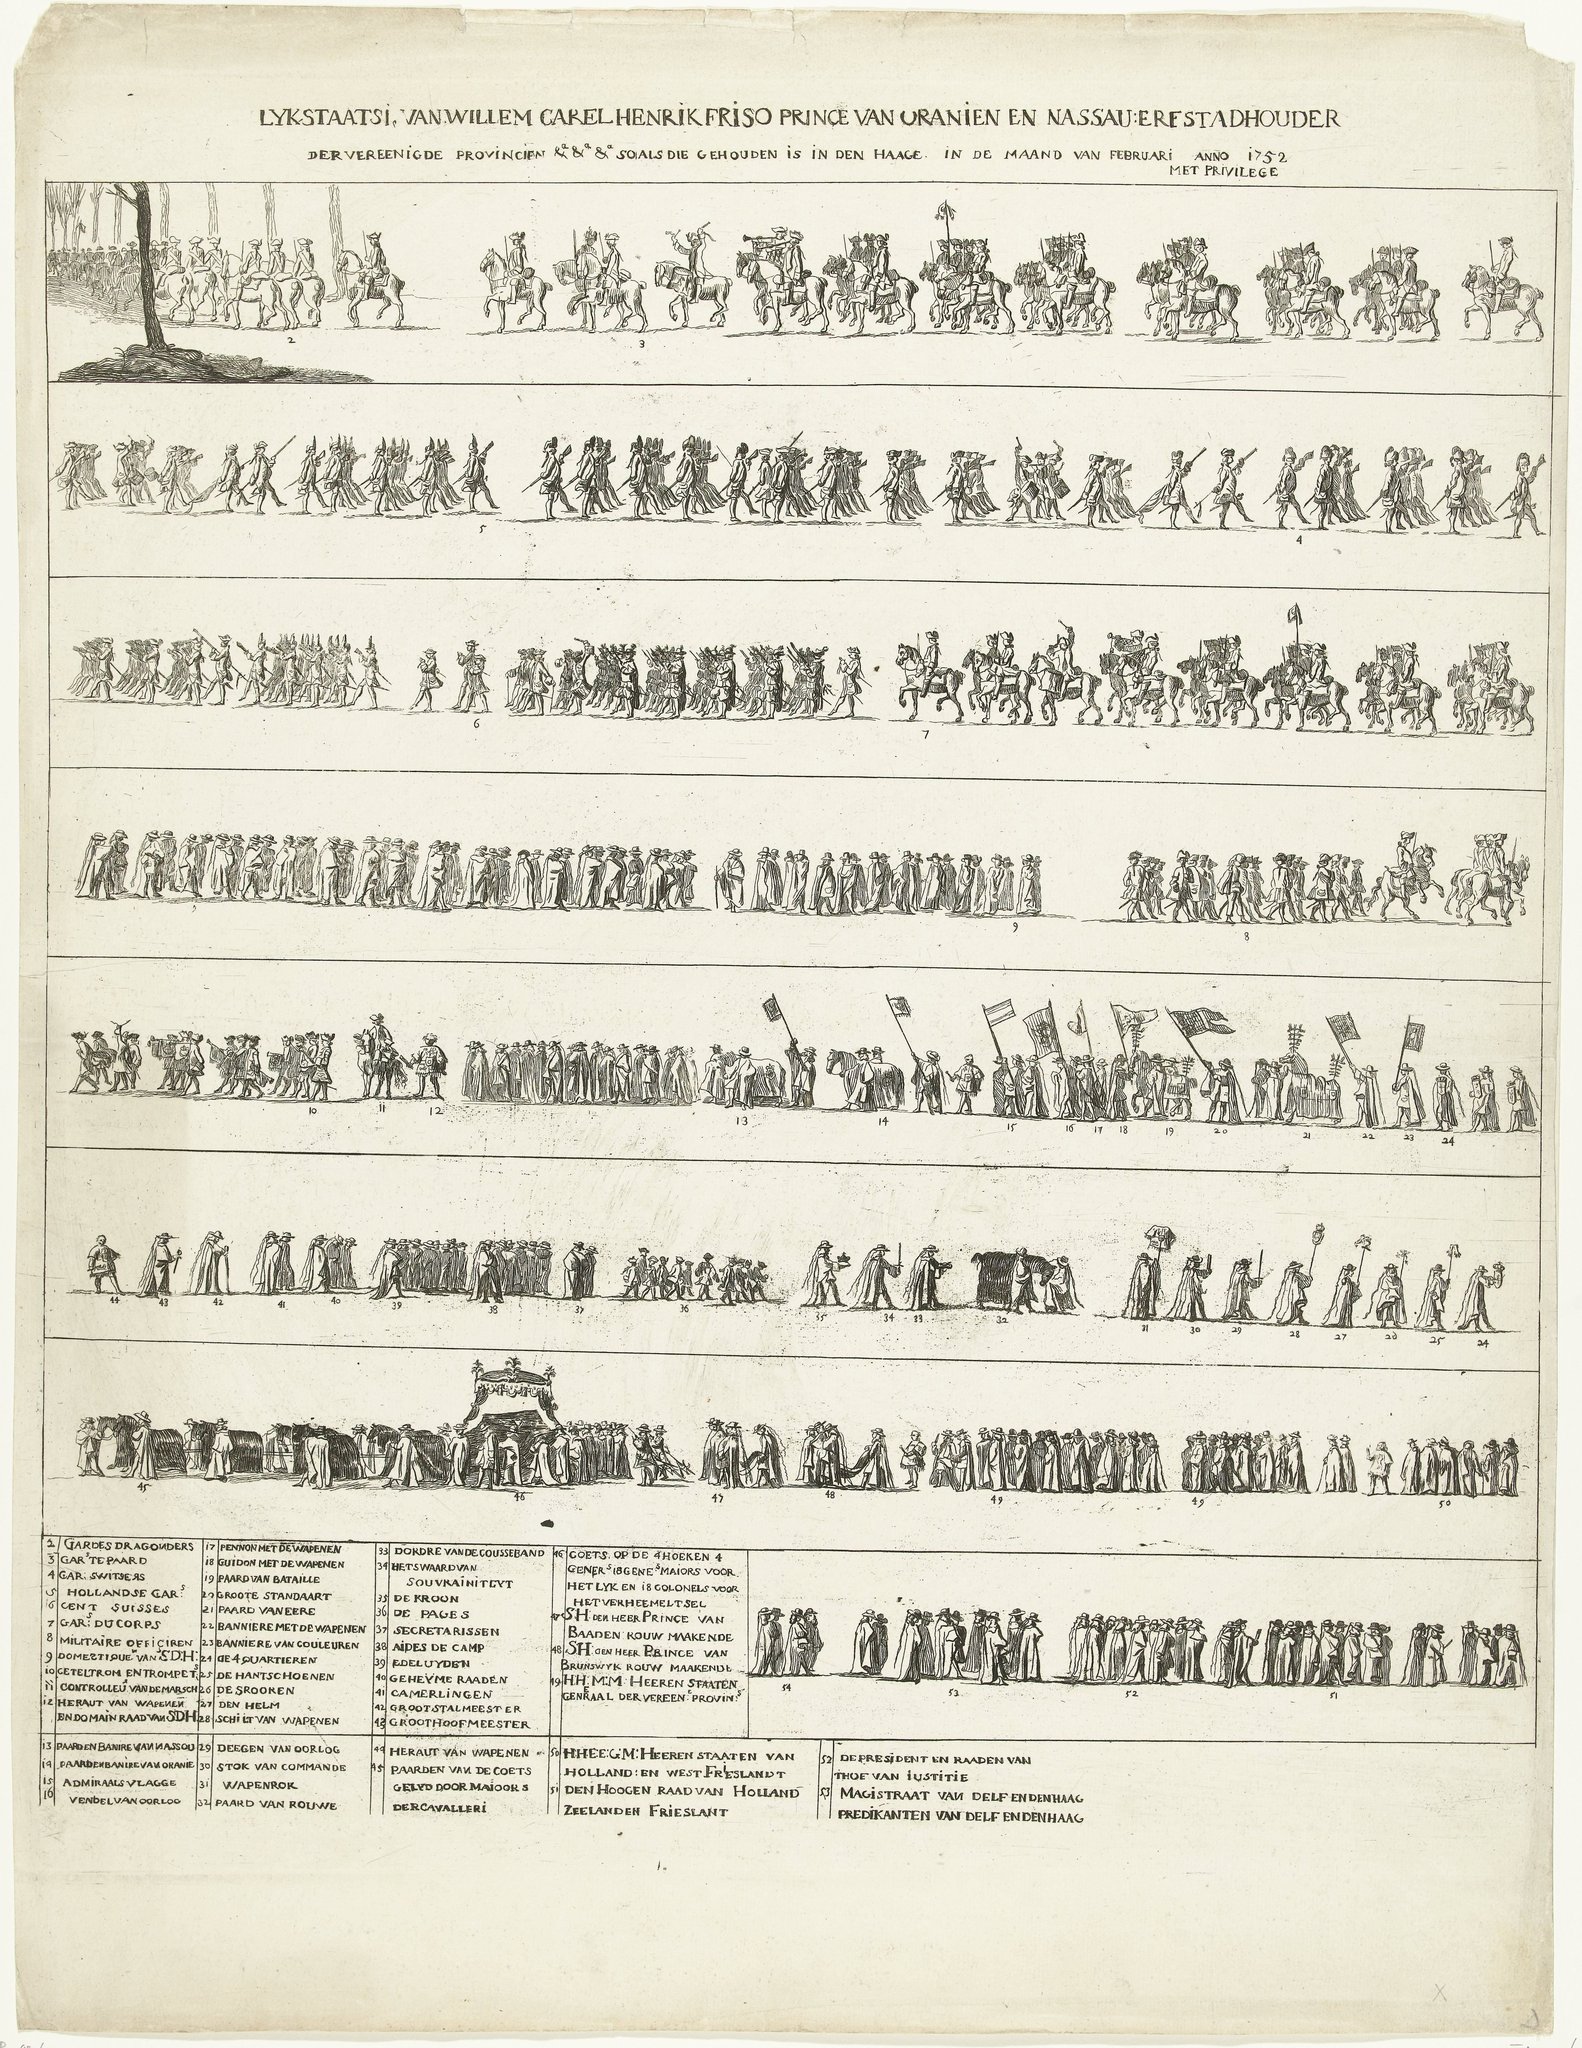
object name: history print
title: Lijkstatie van Johan Willem Carel Hendrik Friso, prins van Oranje en Nassau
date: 1752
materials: paper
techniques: etching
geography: amsterdam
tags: the hague, willem iv (prins van oranje-nassau), cortege, funeral procession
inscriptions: collector's mark: Lugt 240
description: De begrafenisstoet van Willem IV Karel Hendrik Friso gehouden in Den Haag, 1751. De prent bestaat uit acht horizontale strippen met deelnemers in de lijkstoet. De deelnemers zijn genummerd en onderaan de prent is een legenda met uitleg per nummer.